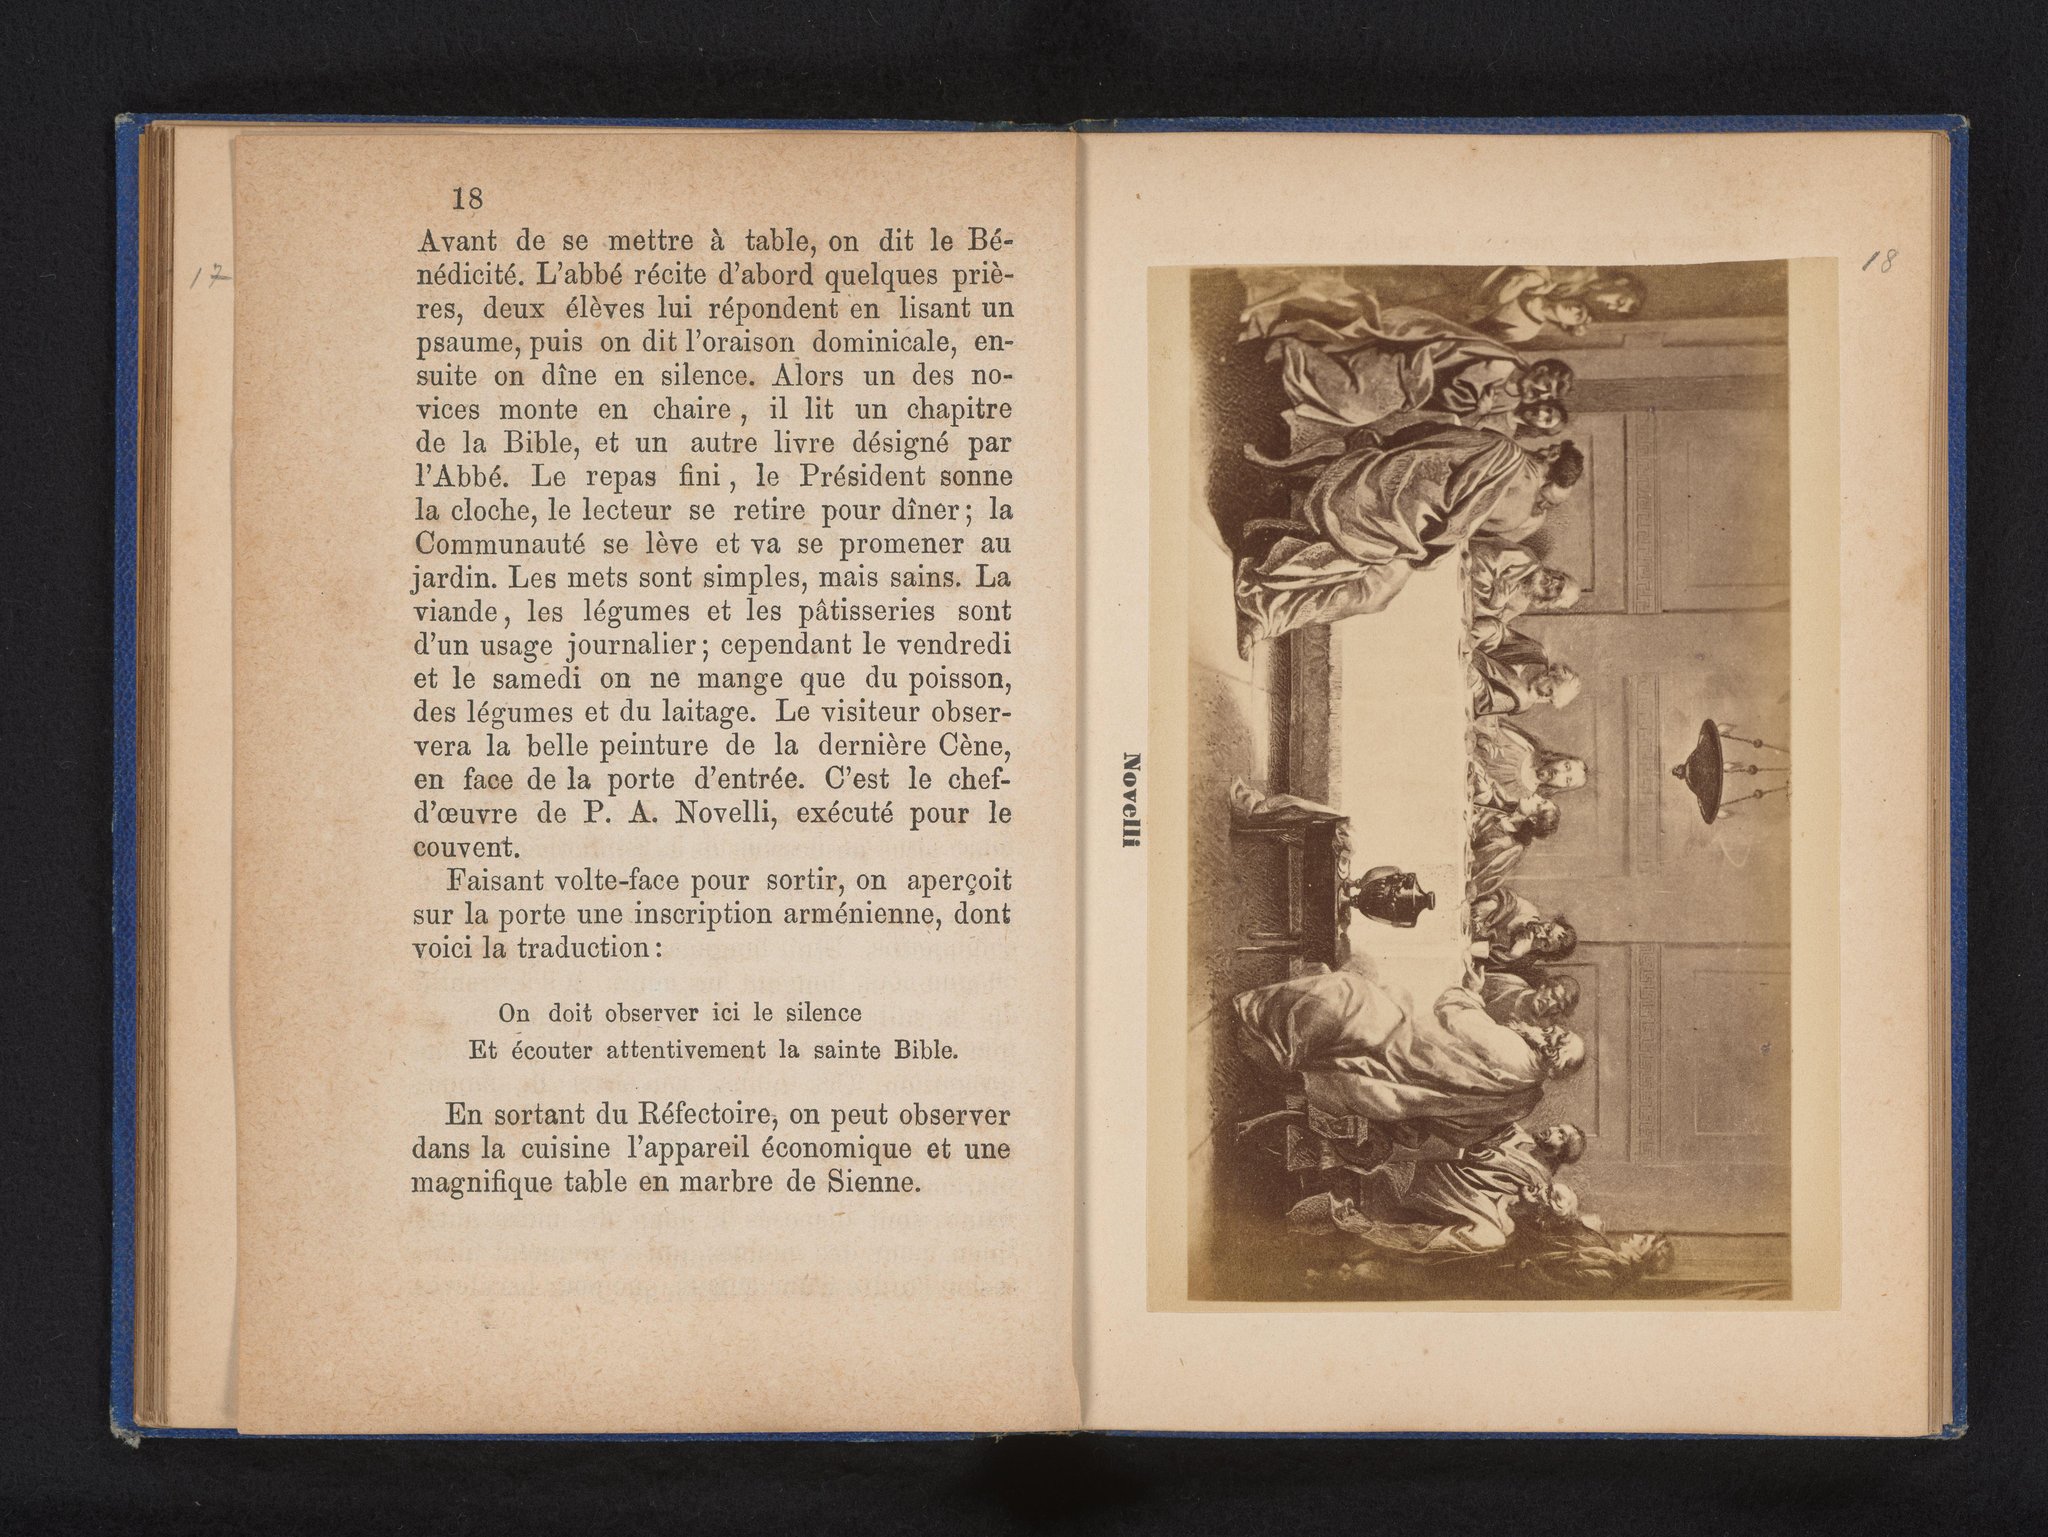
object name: reproduction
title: Fotoreproductie van een fresco van het Laatste Avondmaal in het klooster van San Lazzaro degli Armeni, Venetië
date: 1874-1879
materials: paper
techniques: albumen print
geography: venice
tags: last supper (in general) (matthew 26:21-35; mark 14:18-31; luke 22:3, 22:15-23; john 13:21-38)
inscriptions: number: ‘18’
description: Foto op ongenummerde pagina tegenover pagina 18.